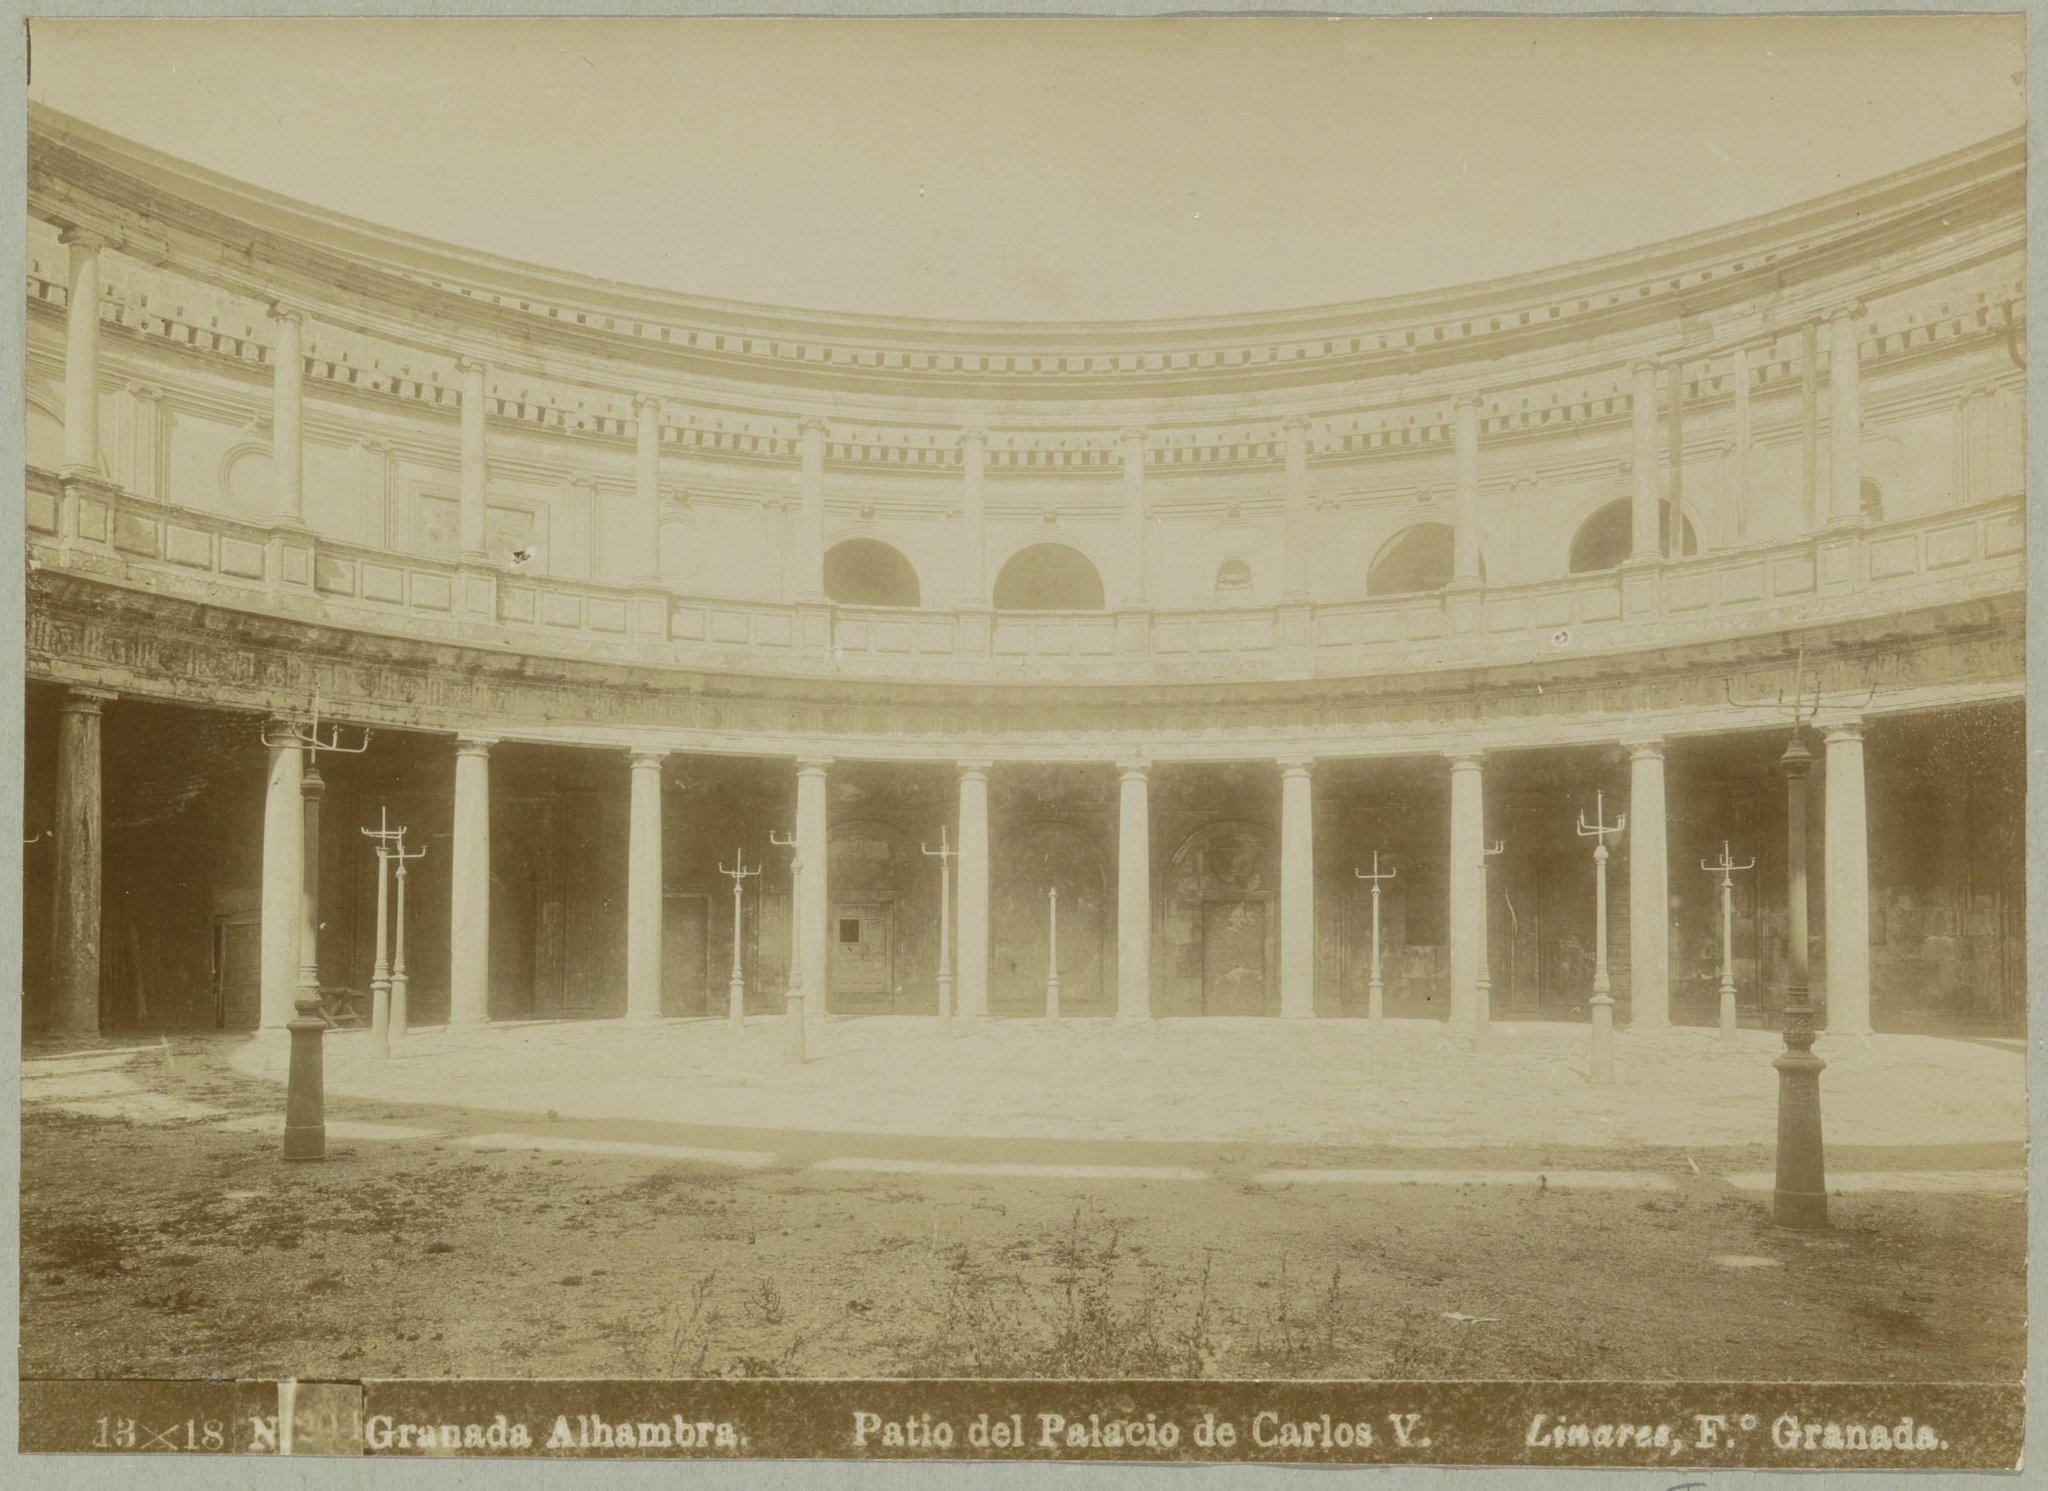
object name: photograph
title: Patio del Palacio de Carlos V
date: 1860-1900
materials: photographic support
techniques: daylight paper print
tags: fortress, column, pillar ~ architecture, palace, courtyard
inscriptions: number: ‘201’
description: Onderdeel van Reisalbum met opnames van het Alhambra in Granada.